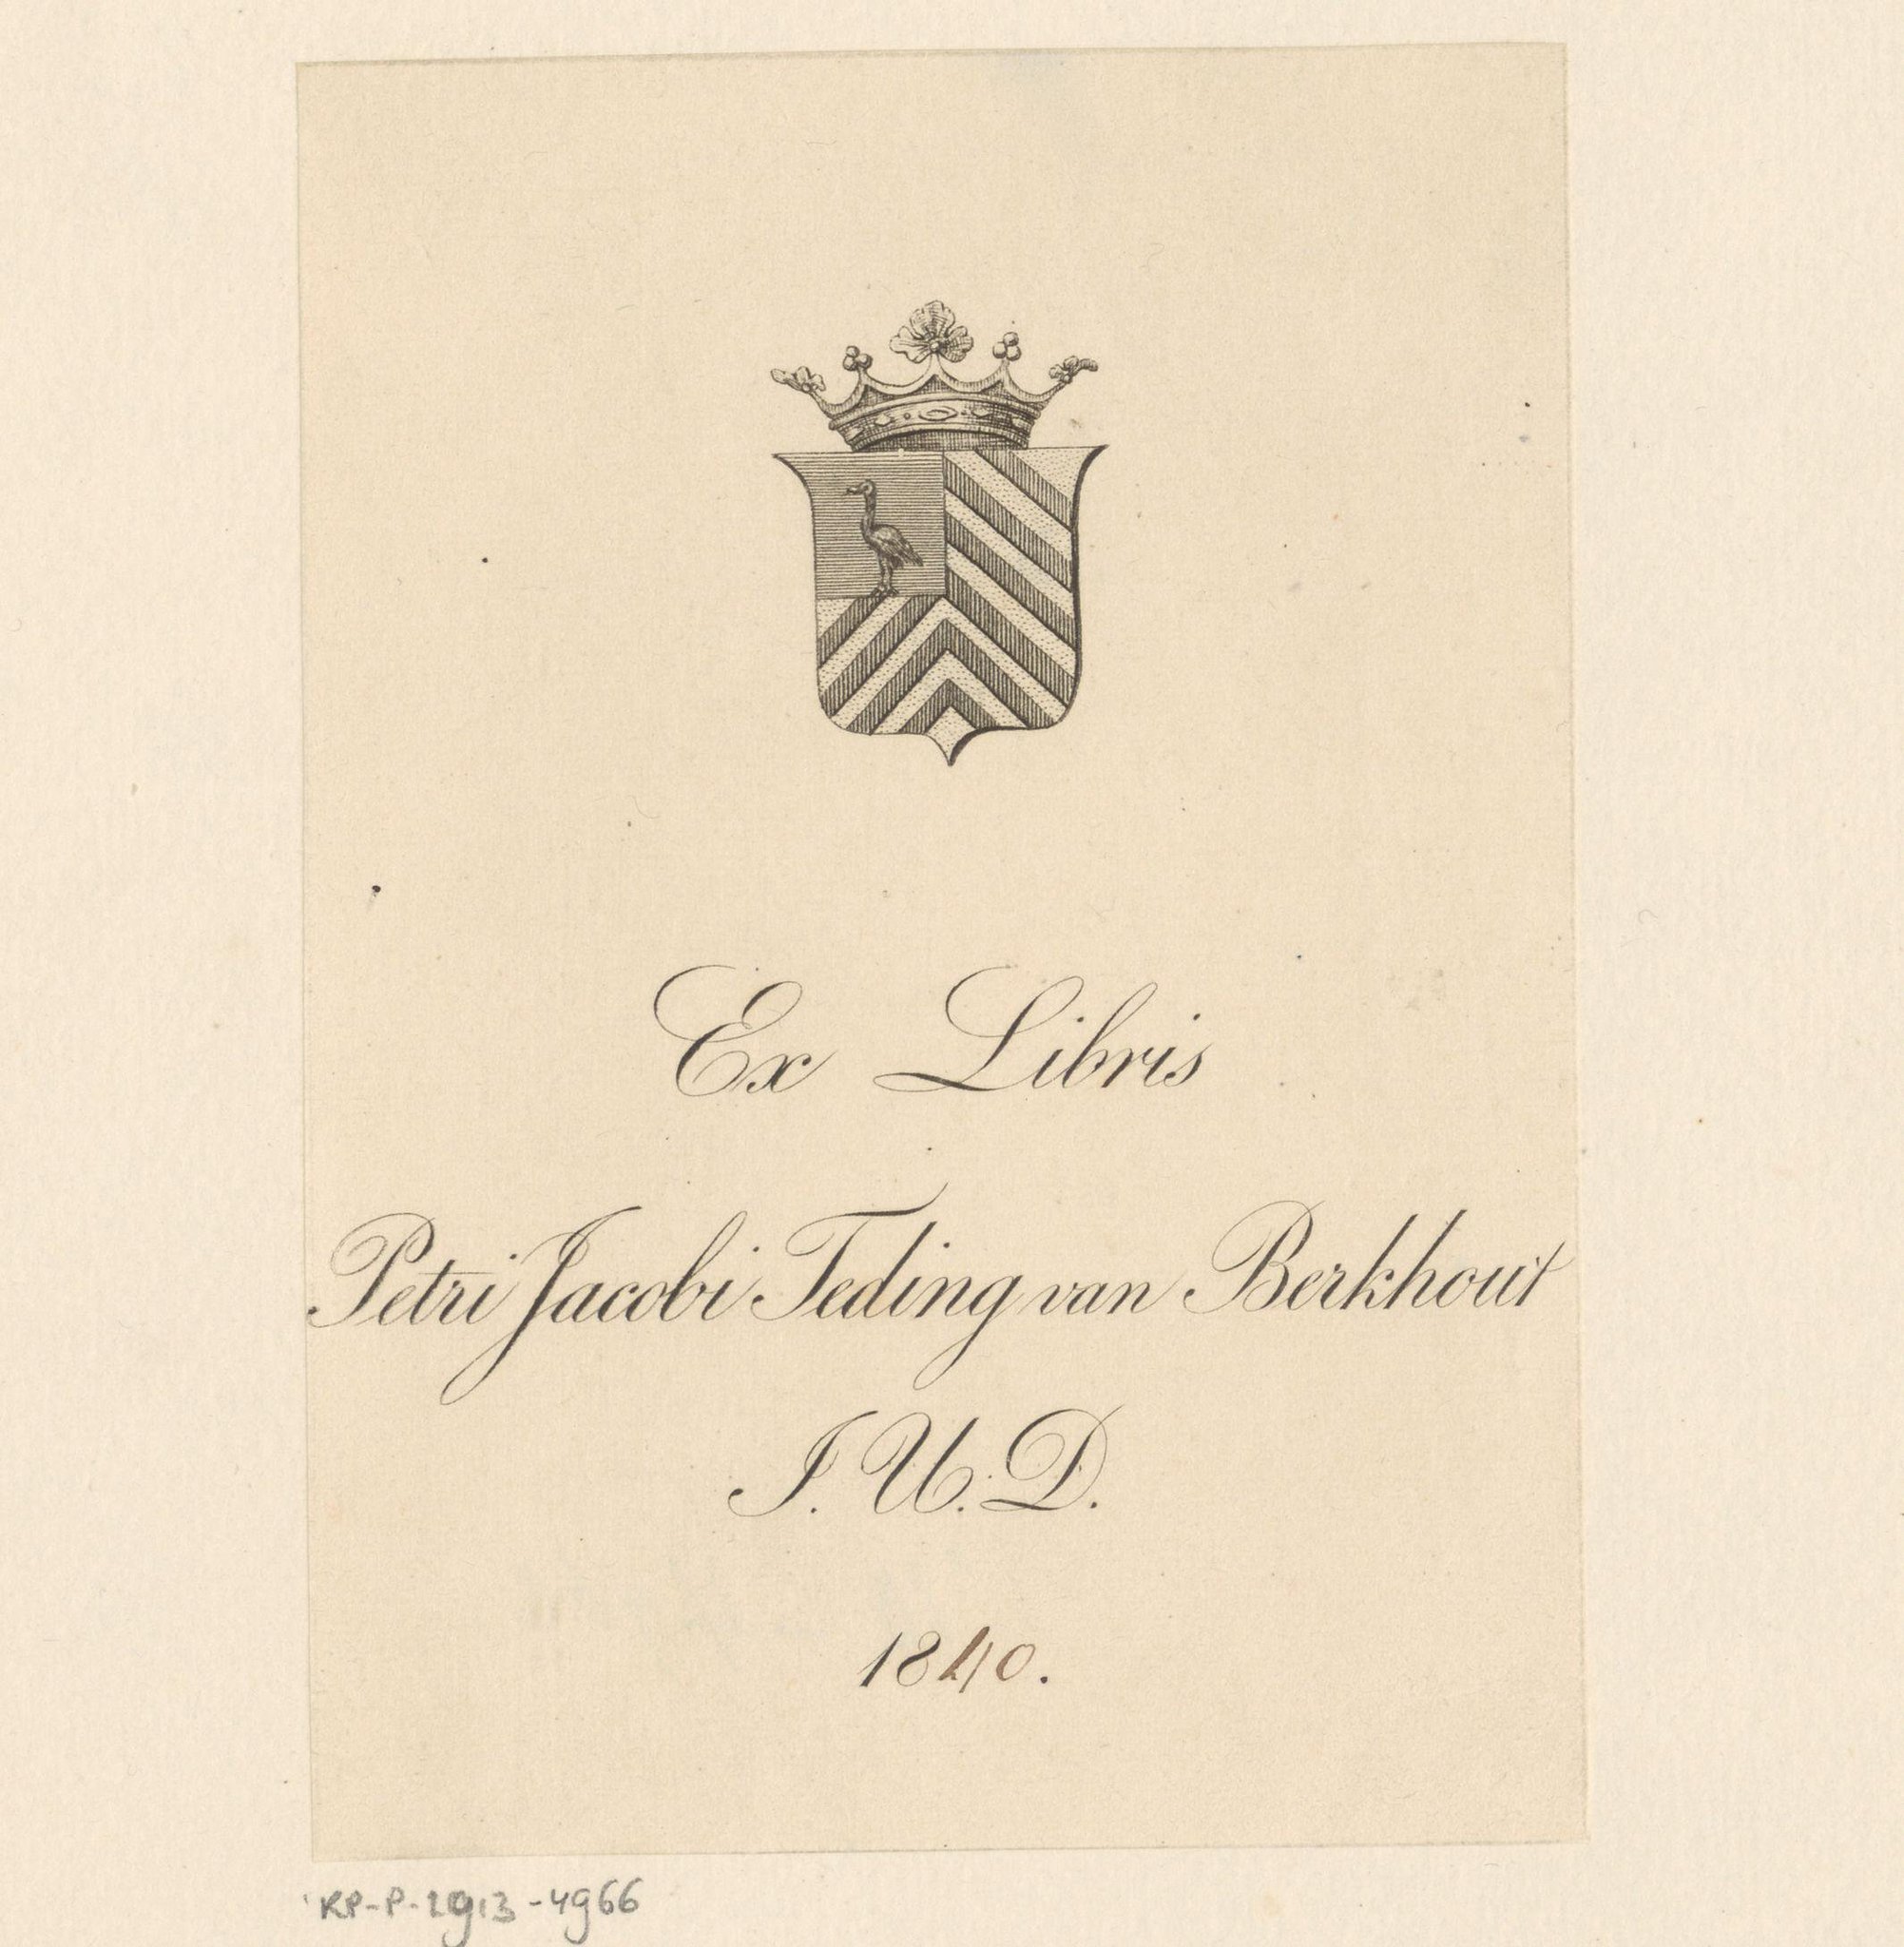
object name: bookplate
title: Ex libris van jonkheer Pieter Jacob van Berkhout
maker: Anonymous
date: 1840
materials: paper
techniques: engraving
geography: netherlands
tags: armorial bearing, heraldry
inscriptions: collector's mark: Lugt 2233, collector's mark: Lugt 2760